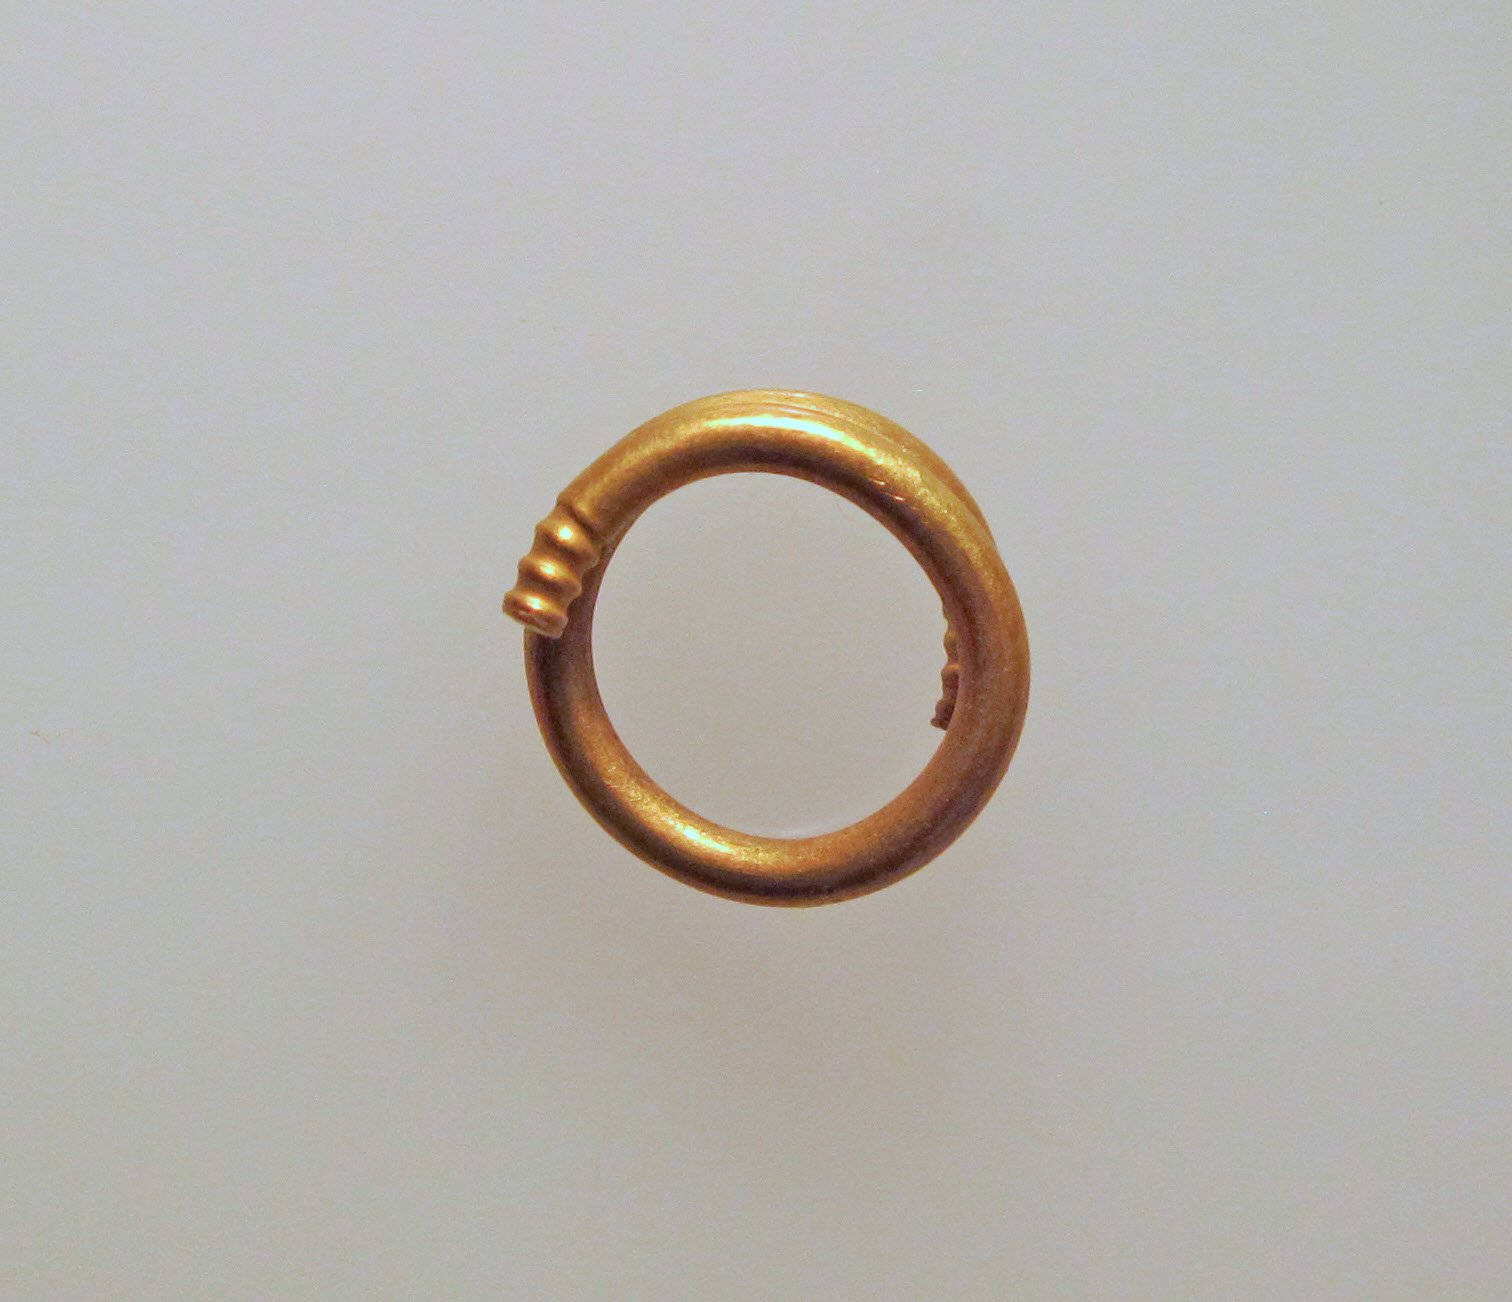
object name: spiral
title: Spirals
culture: cypriot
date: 3900 BCE-100 CE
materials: gold